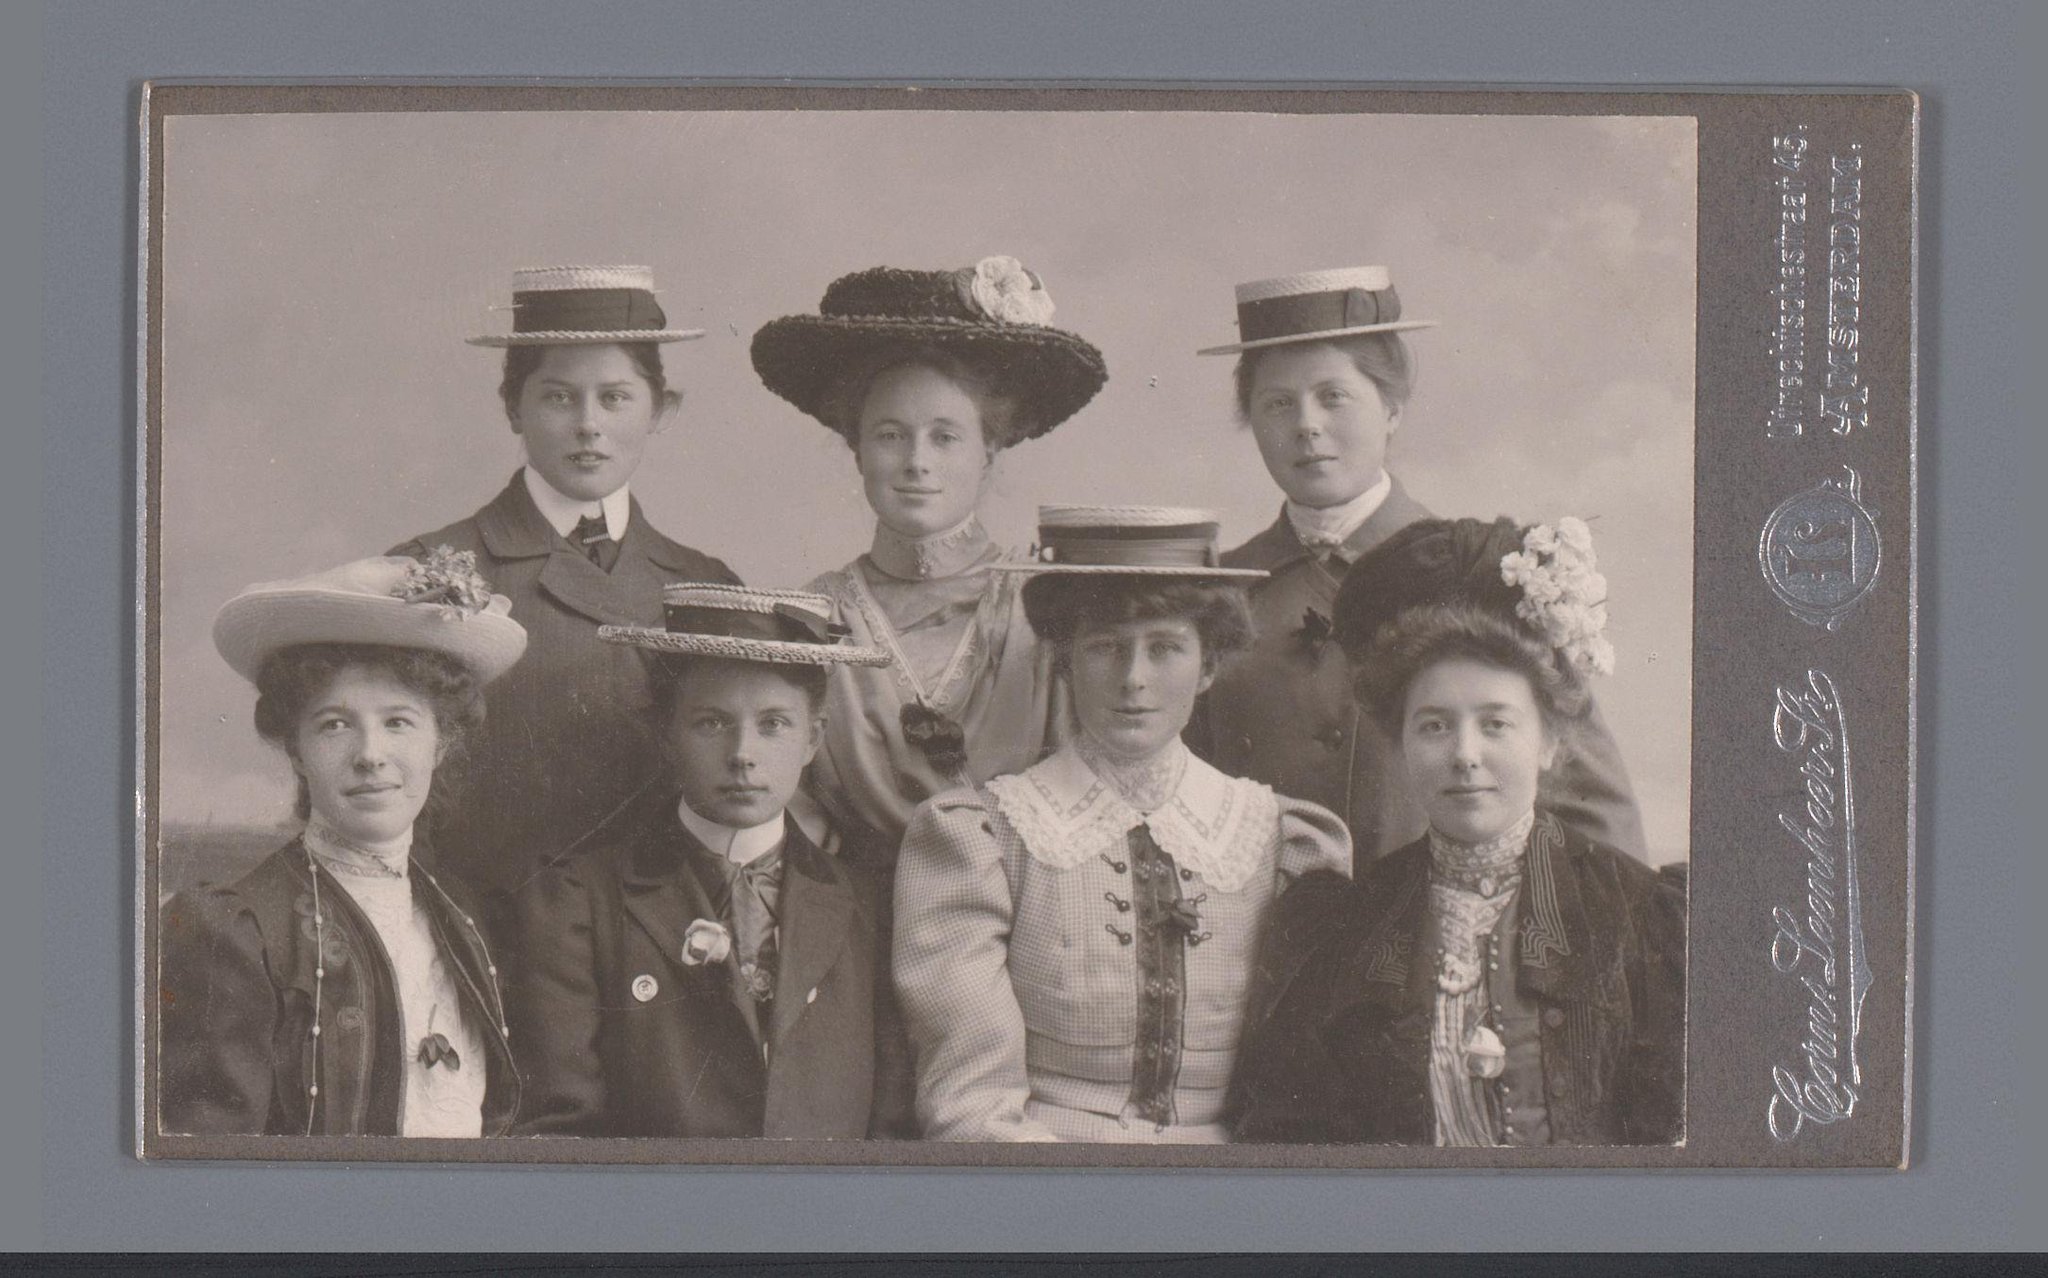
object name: photograph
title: Groepsportret van zeven vrouwen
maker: cornelis leenheer jr.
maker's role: fotograaf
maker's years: 1869-1942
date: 1906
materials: cardboard, photographic support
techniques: collodion silver print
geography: amsterdam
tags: historical persons, amsterdam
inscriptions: annotation: ‘Met z.o.z. bent ik nu klaar. 't Afscheid is niet minnetjes. Zeven kindertjes bij elkaar. 't Dispuut met twee vriendinnetjes.’, date: ‘22-4-'06’